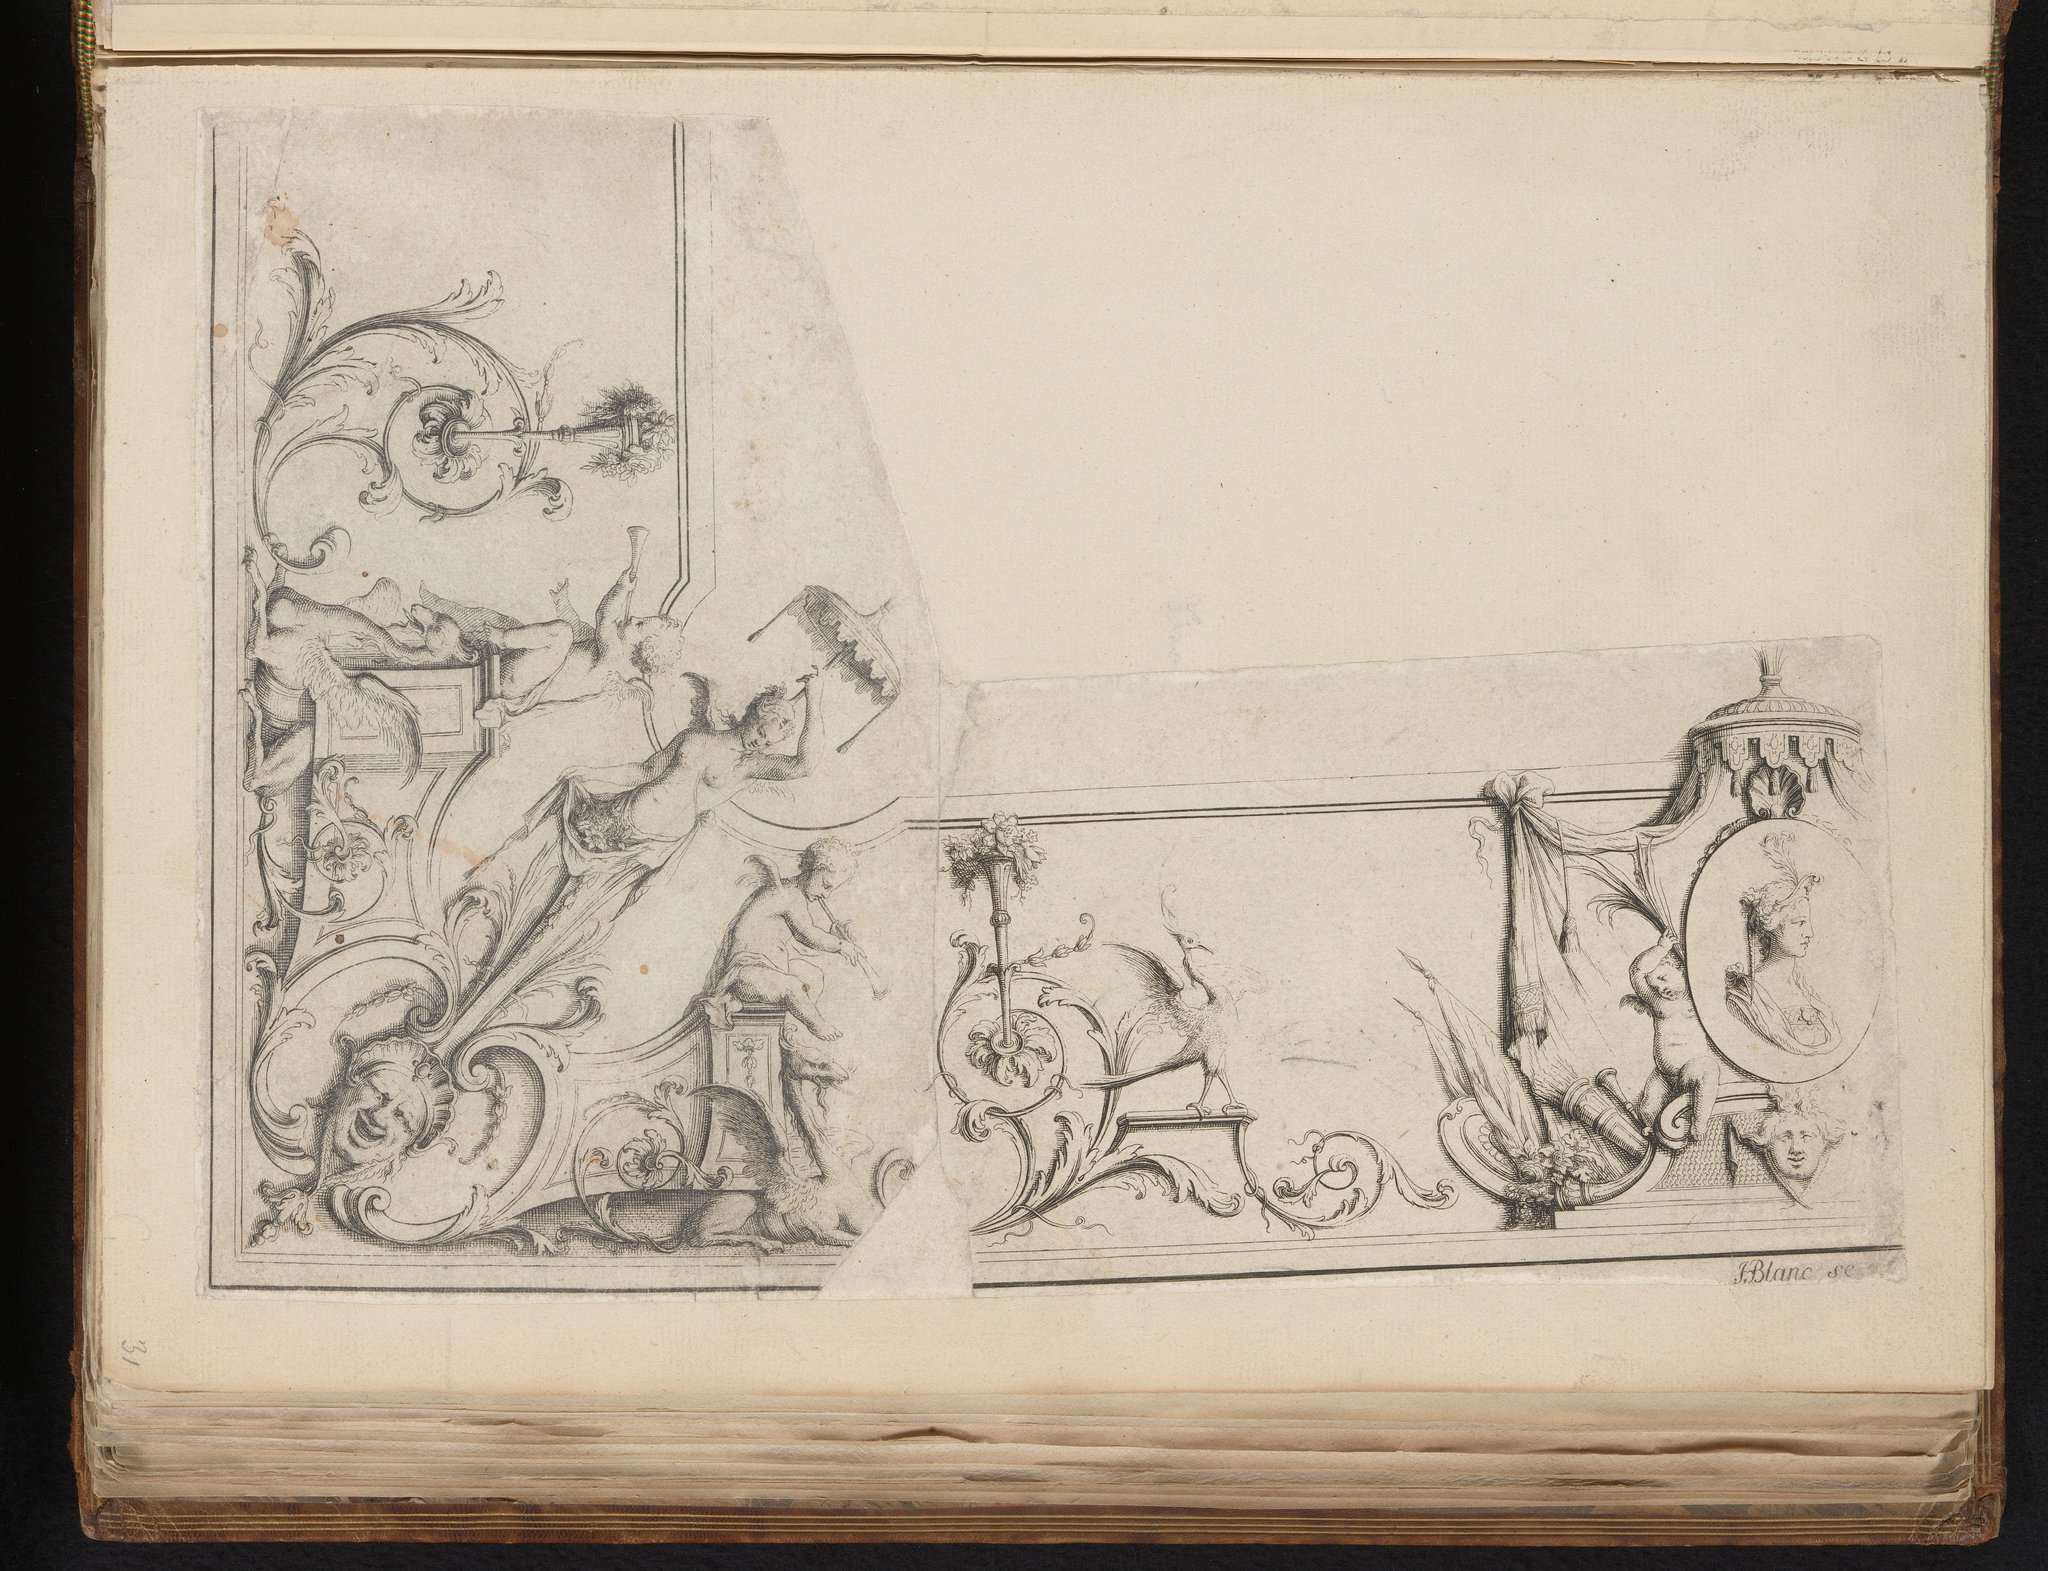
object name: ornament print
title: Desseins a plusieurs usages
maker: honoré blanc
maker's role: print maker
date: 1682-1734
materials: paper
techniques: etching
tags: ornaments ~ art, canopy, baldachin, other hybrid forms in the shape of a pillar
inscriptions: collector's mark: Lugt 2760, collector's mark: Lugt 2228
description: Prent maakt deel uit van een serie van zes prenten.